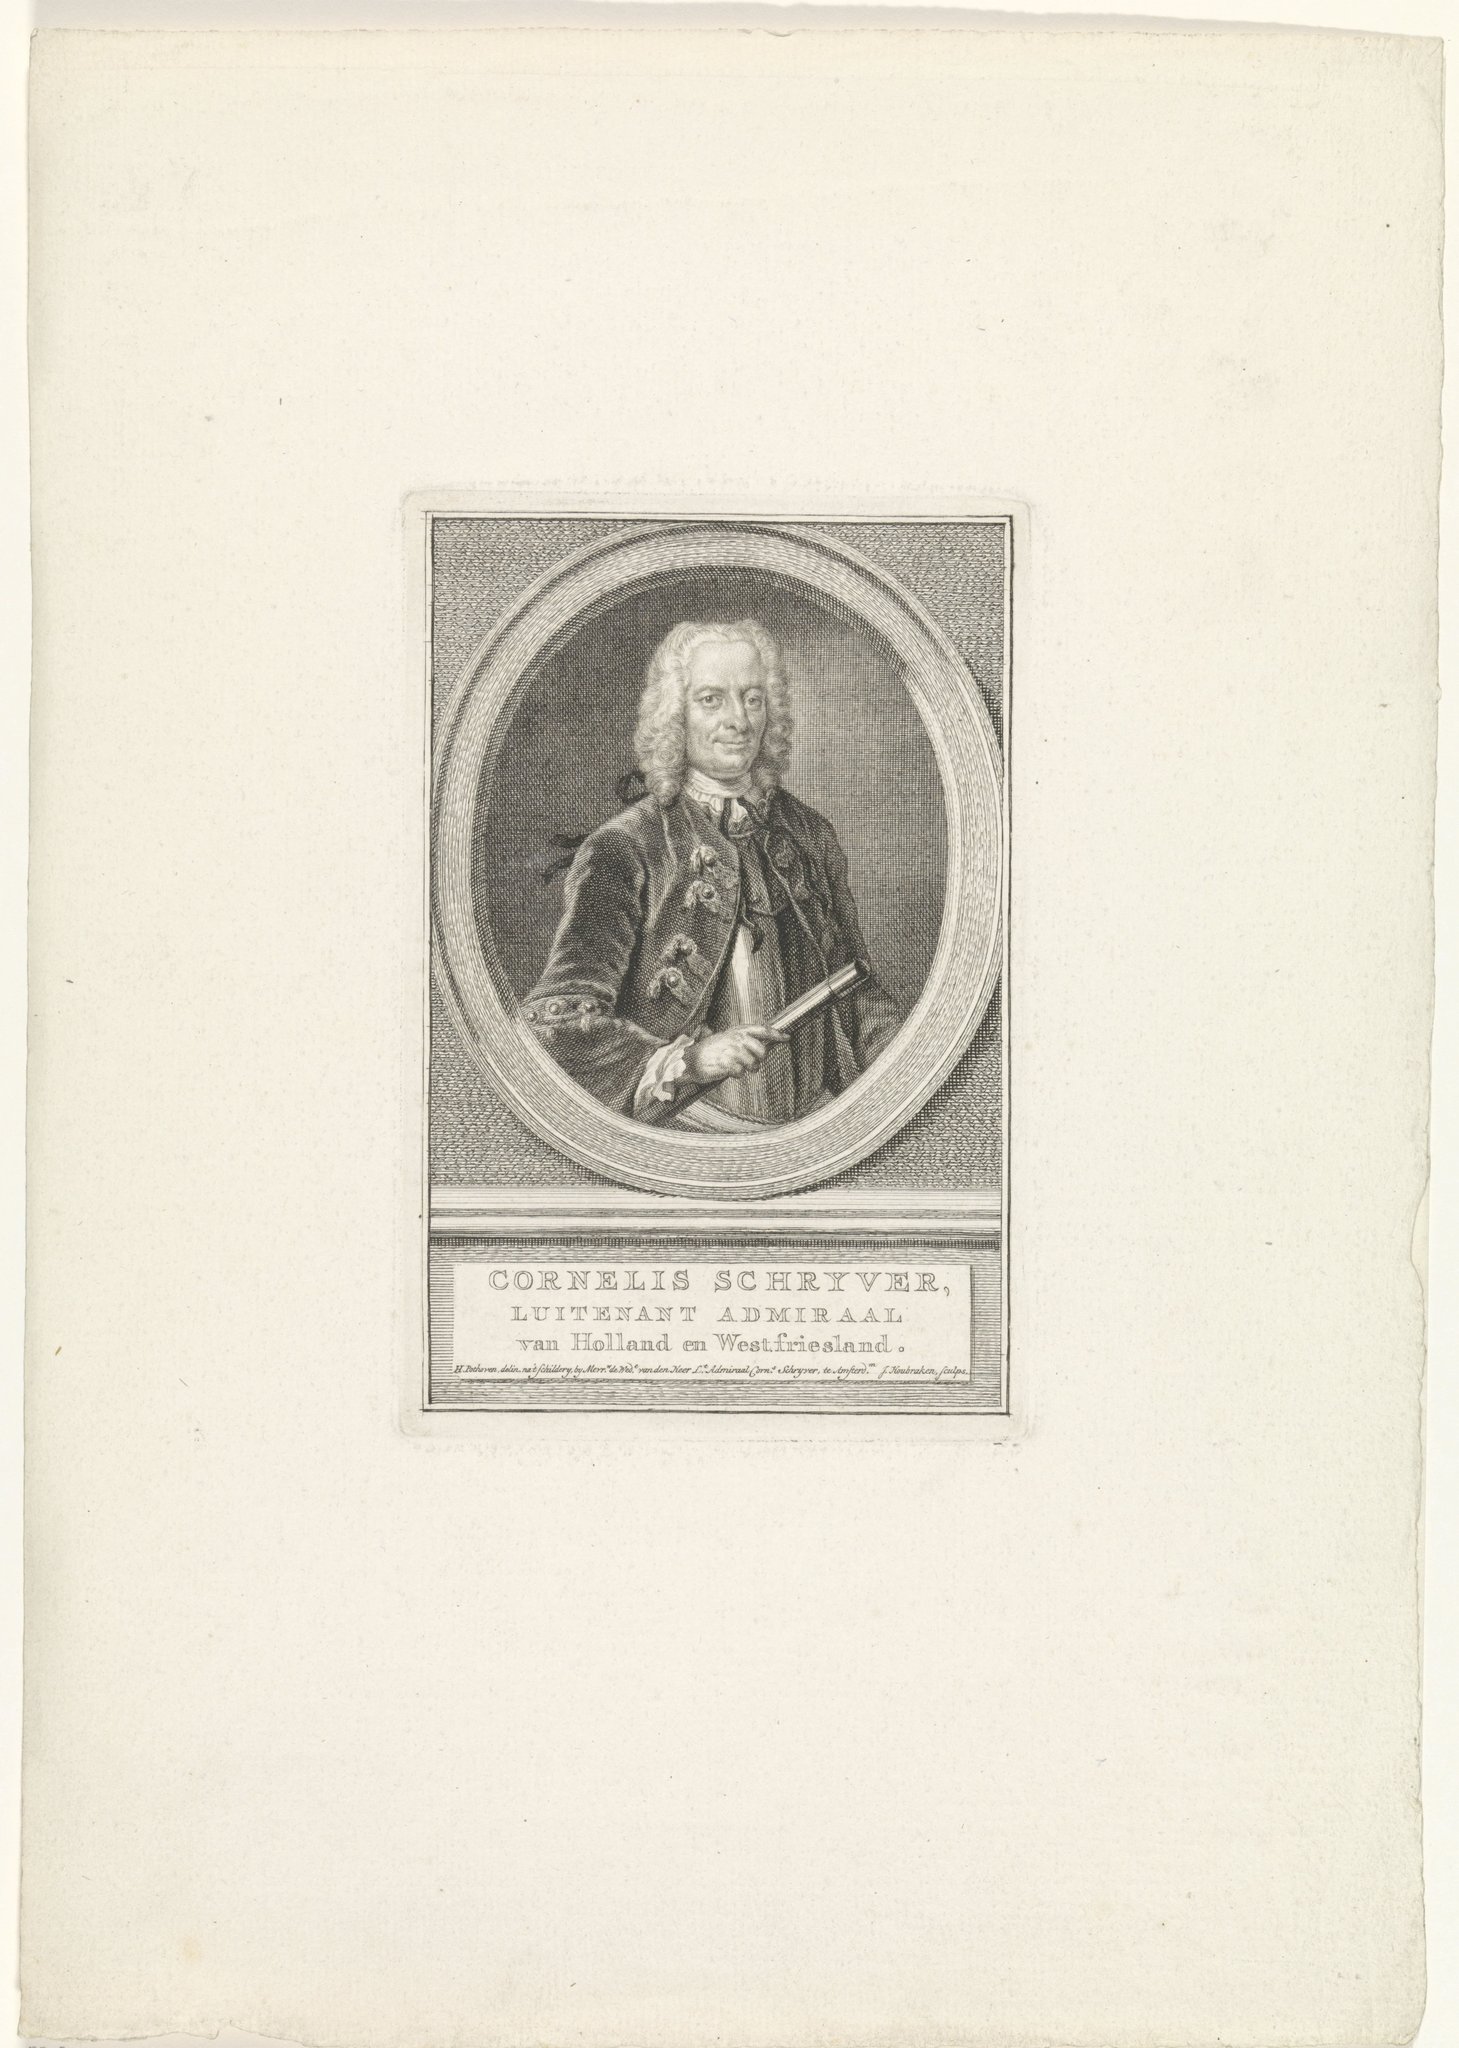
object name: print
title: Portret van Cornelis Schrijver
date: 1749-1759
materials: paper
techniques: engraving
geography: amsterdam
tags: schrijver, cornelis schrijver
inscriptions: collector's mark: Lugt 2228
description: Prent oorspronkelijk bedoeld voor: Jan Wagenaar, Vaderlandsche historie, vervattende de geschiedenissen der nu Vereenigde Nederlanden, inzonderheid die van Holland (...), 21 delen. Amsterdam, Isaak Tirion, 1749-59.